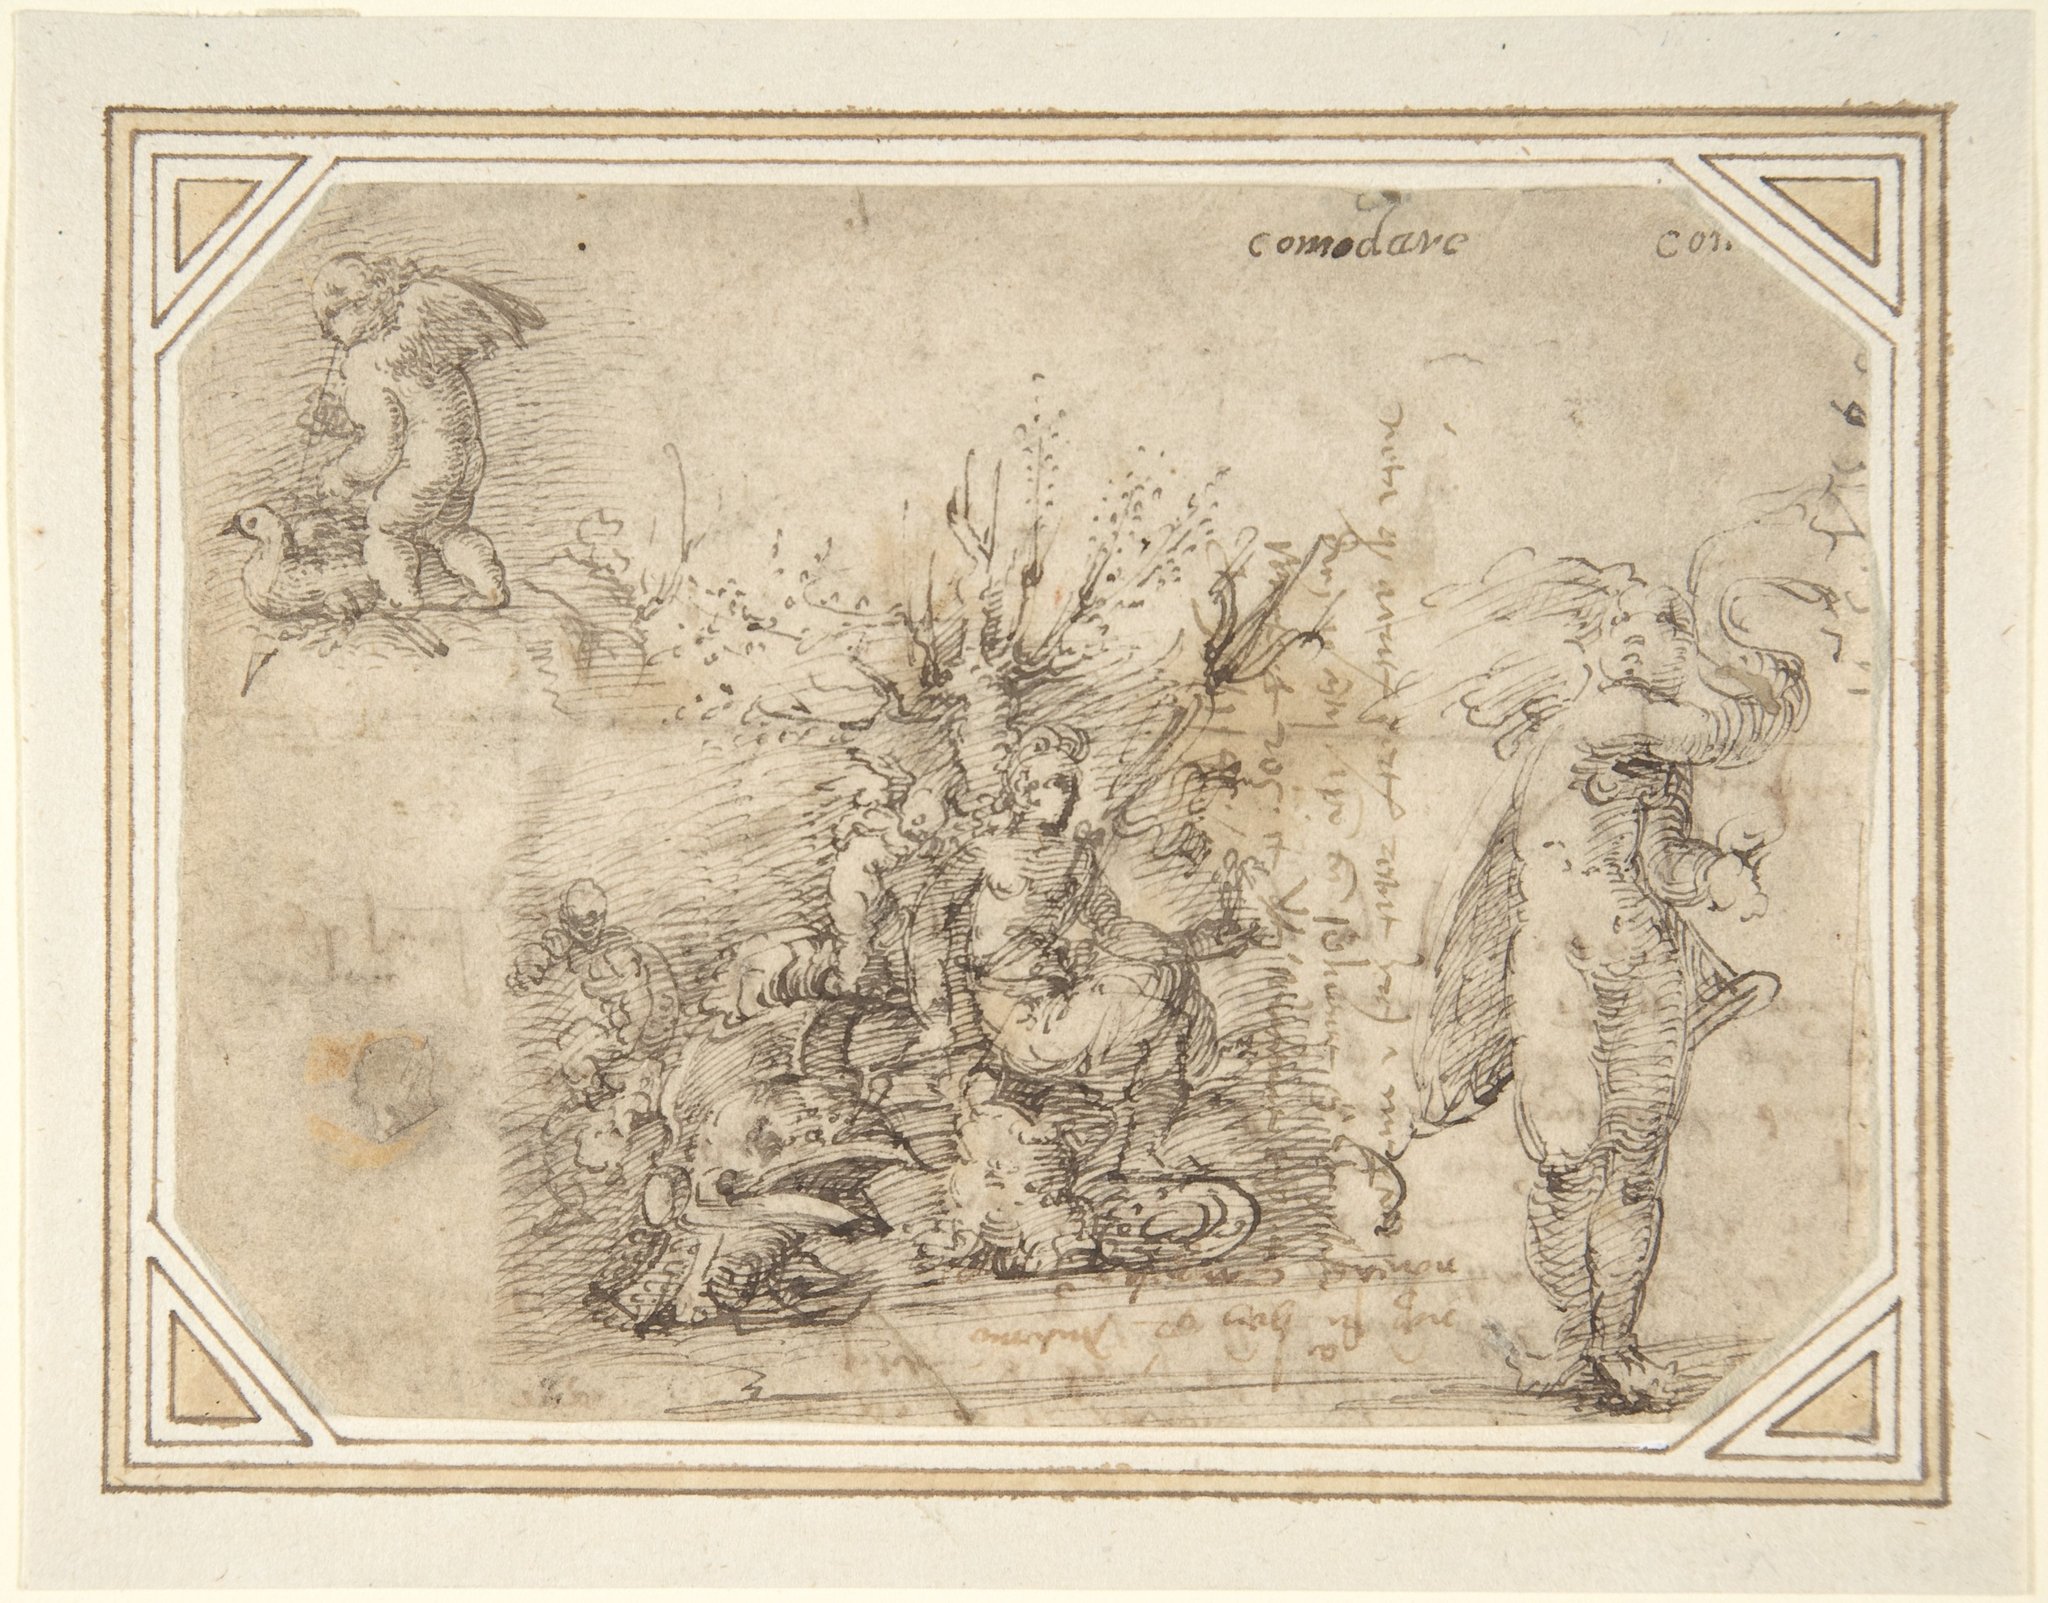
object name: drawing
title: Allegory of Peace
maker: anonymous, german, 16th century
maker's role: artist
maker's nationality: german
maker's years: 1500-1600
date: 1520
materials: ink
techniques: pen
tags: birds,peace,women